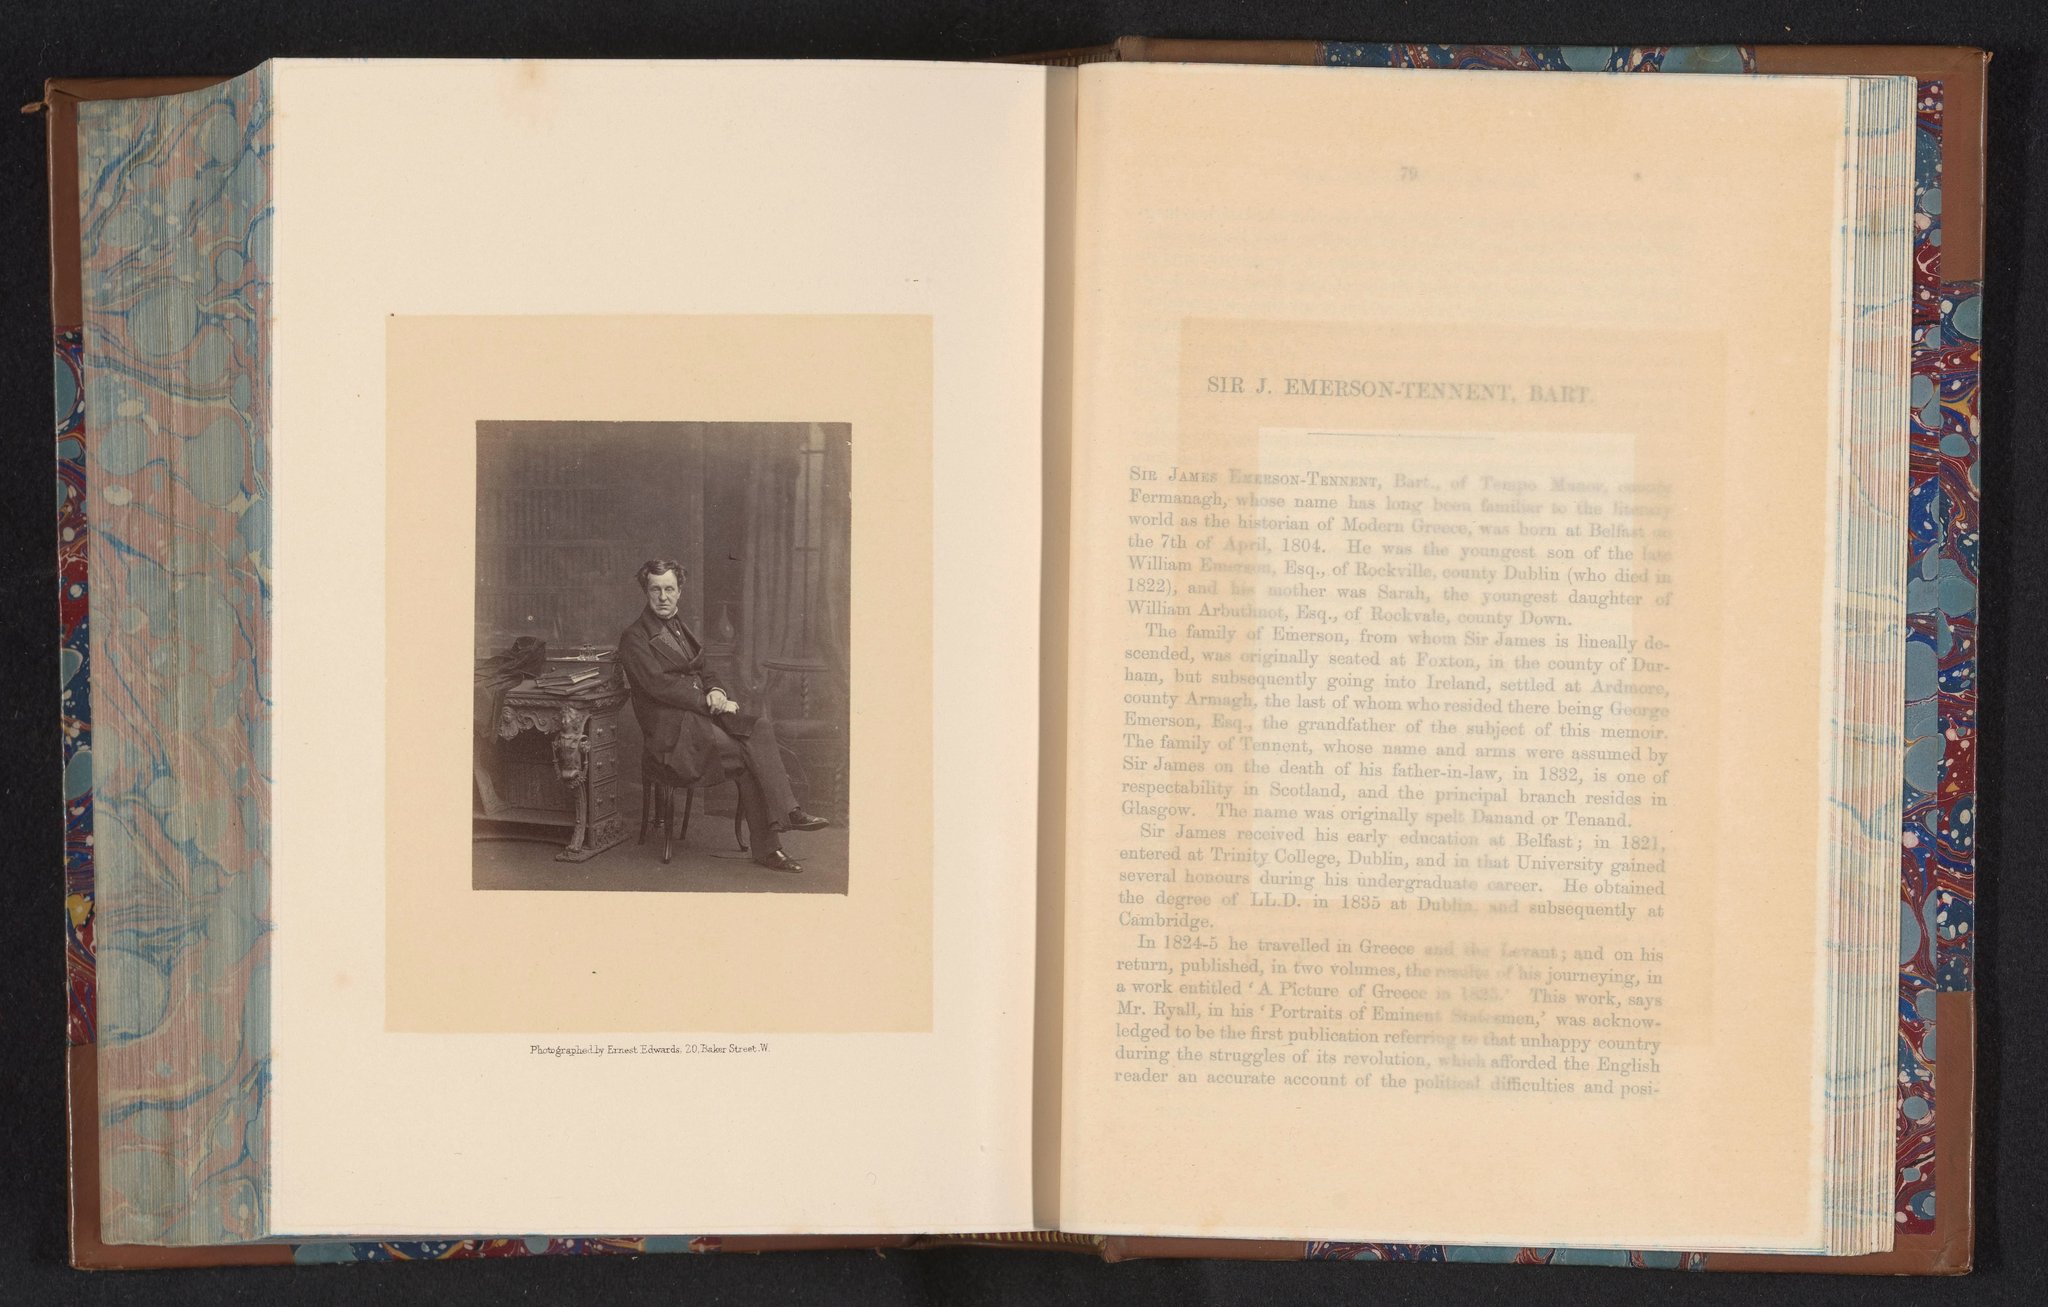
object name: page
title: Portret van James Emerson Tennent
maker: ernest edwards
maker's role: fotograaf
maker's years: 1837-1903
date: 1853-1867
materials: photographic support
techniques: albumen print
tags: traveler, politician, e.g. party leader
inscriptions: name: ‘Photographed by Ernest Edwards, 20, Baker Street. W.’